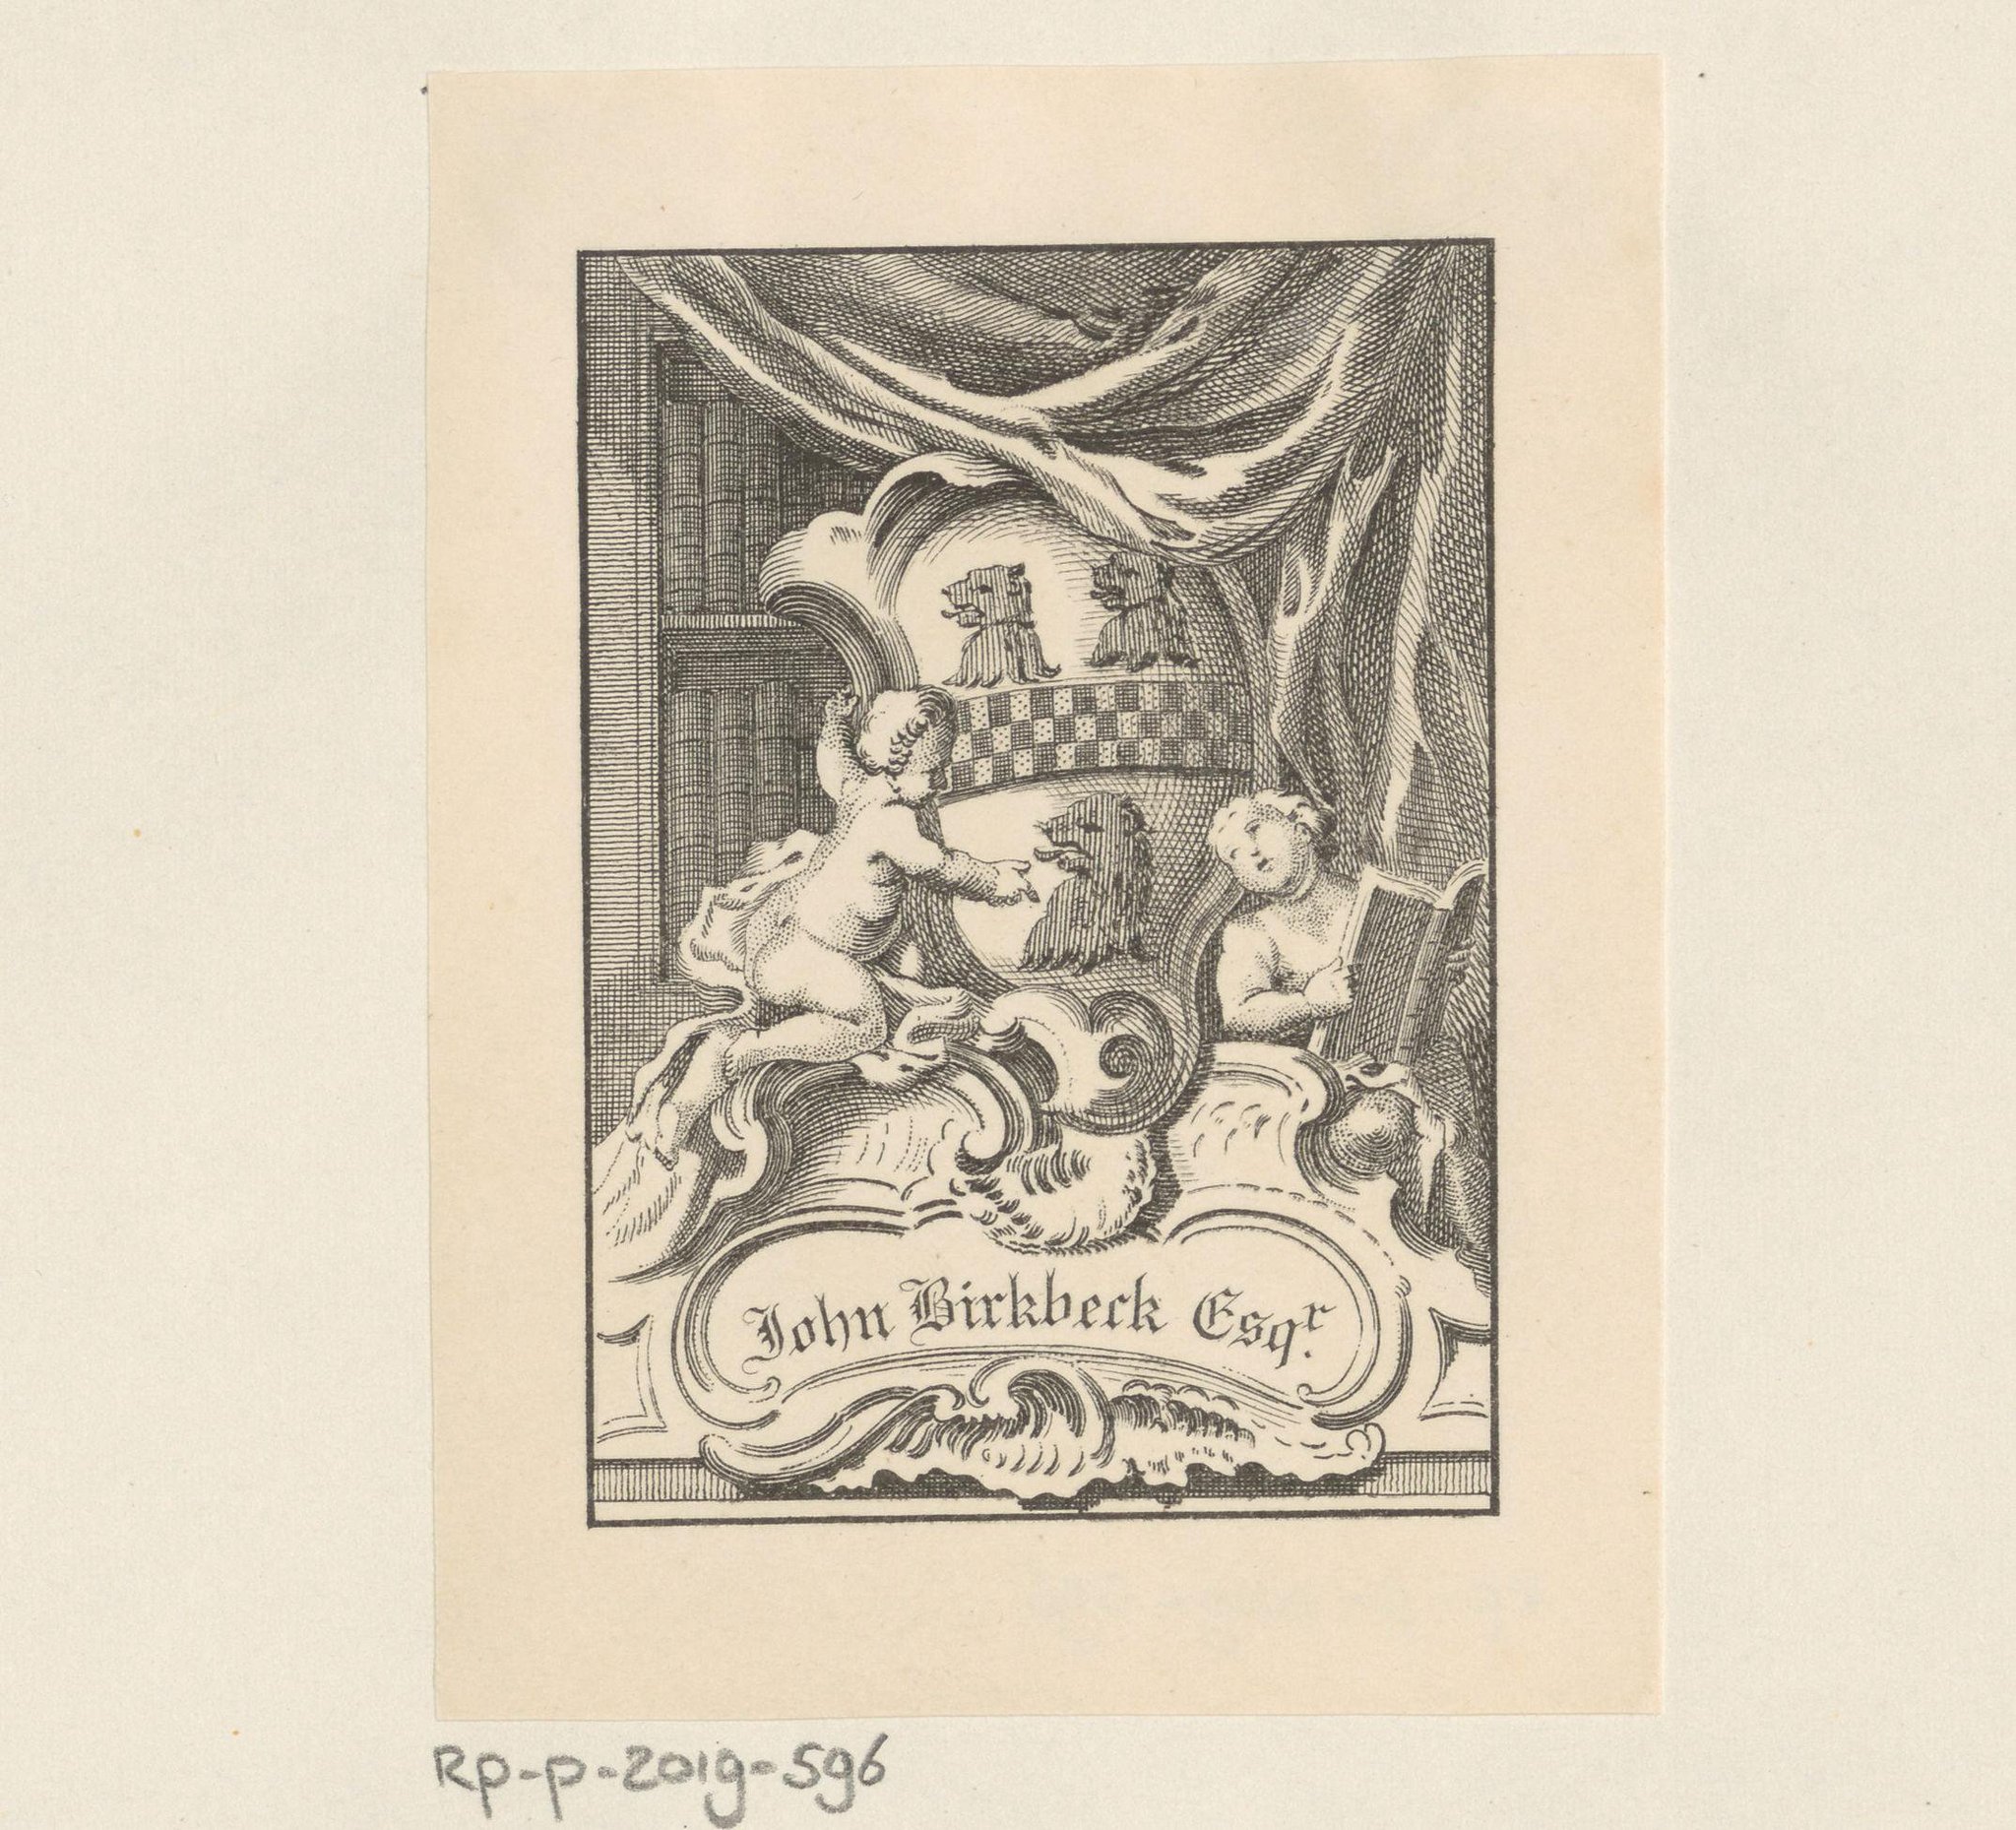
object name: bookplate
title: Ex libris van John Birkbeck Esqr.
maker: Anonymous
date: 1800-1899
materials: paper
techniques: engraving, etching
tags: study; 'studiolo'; library